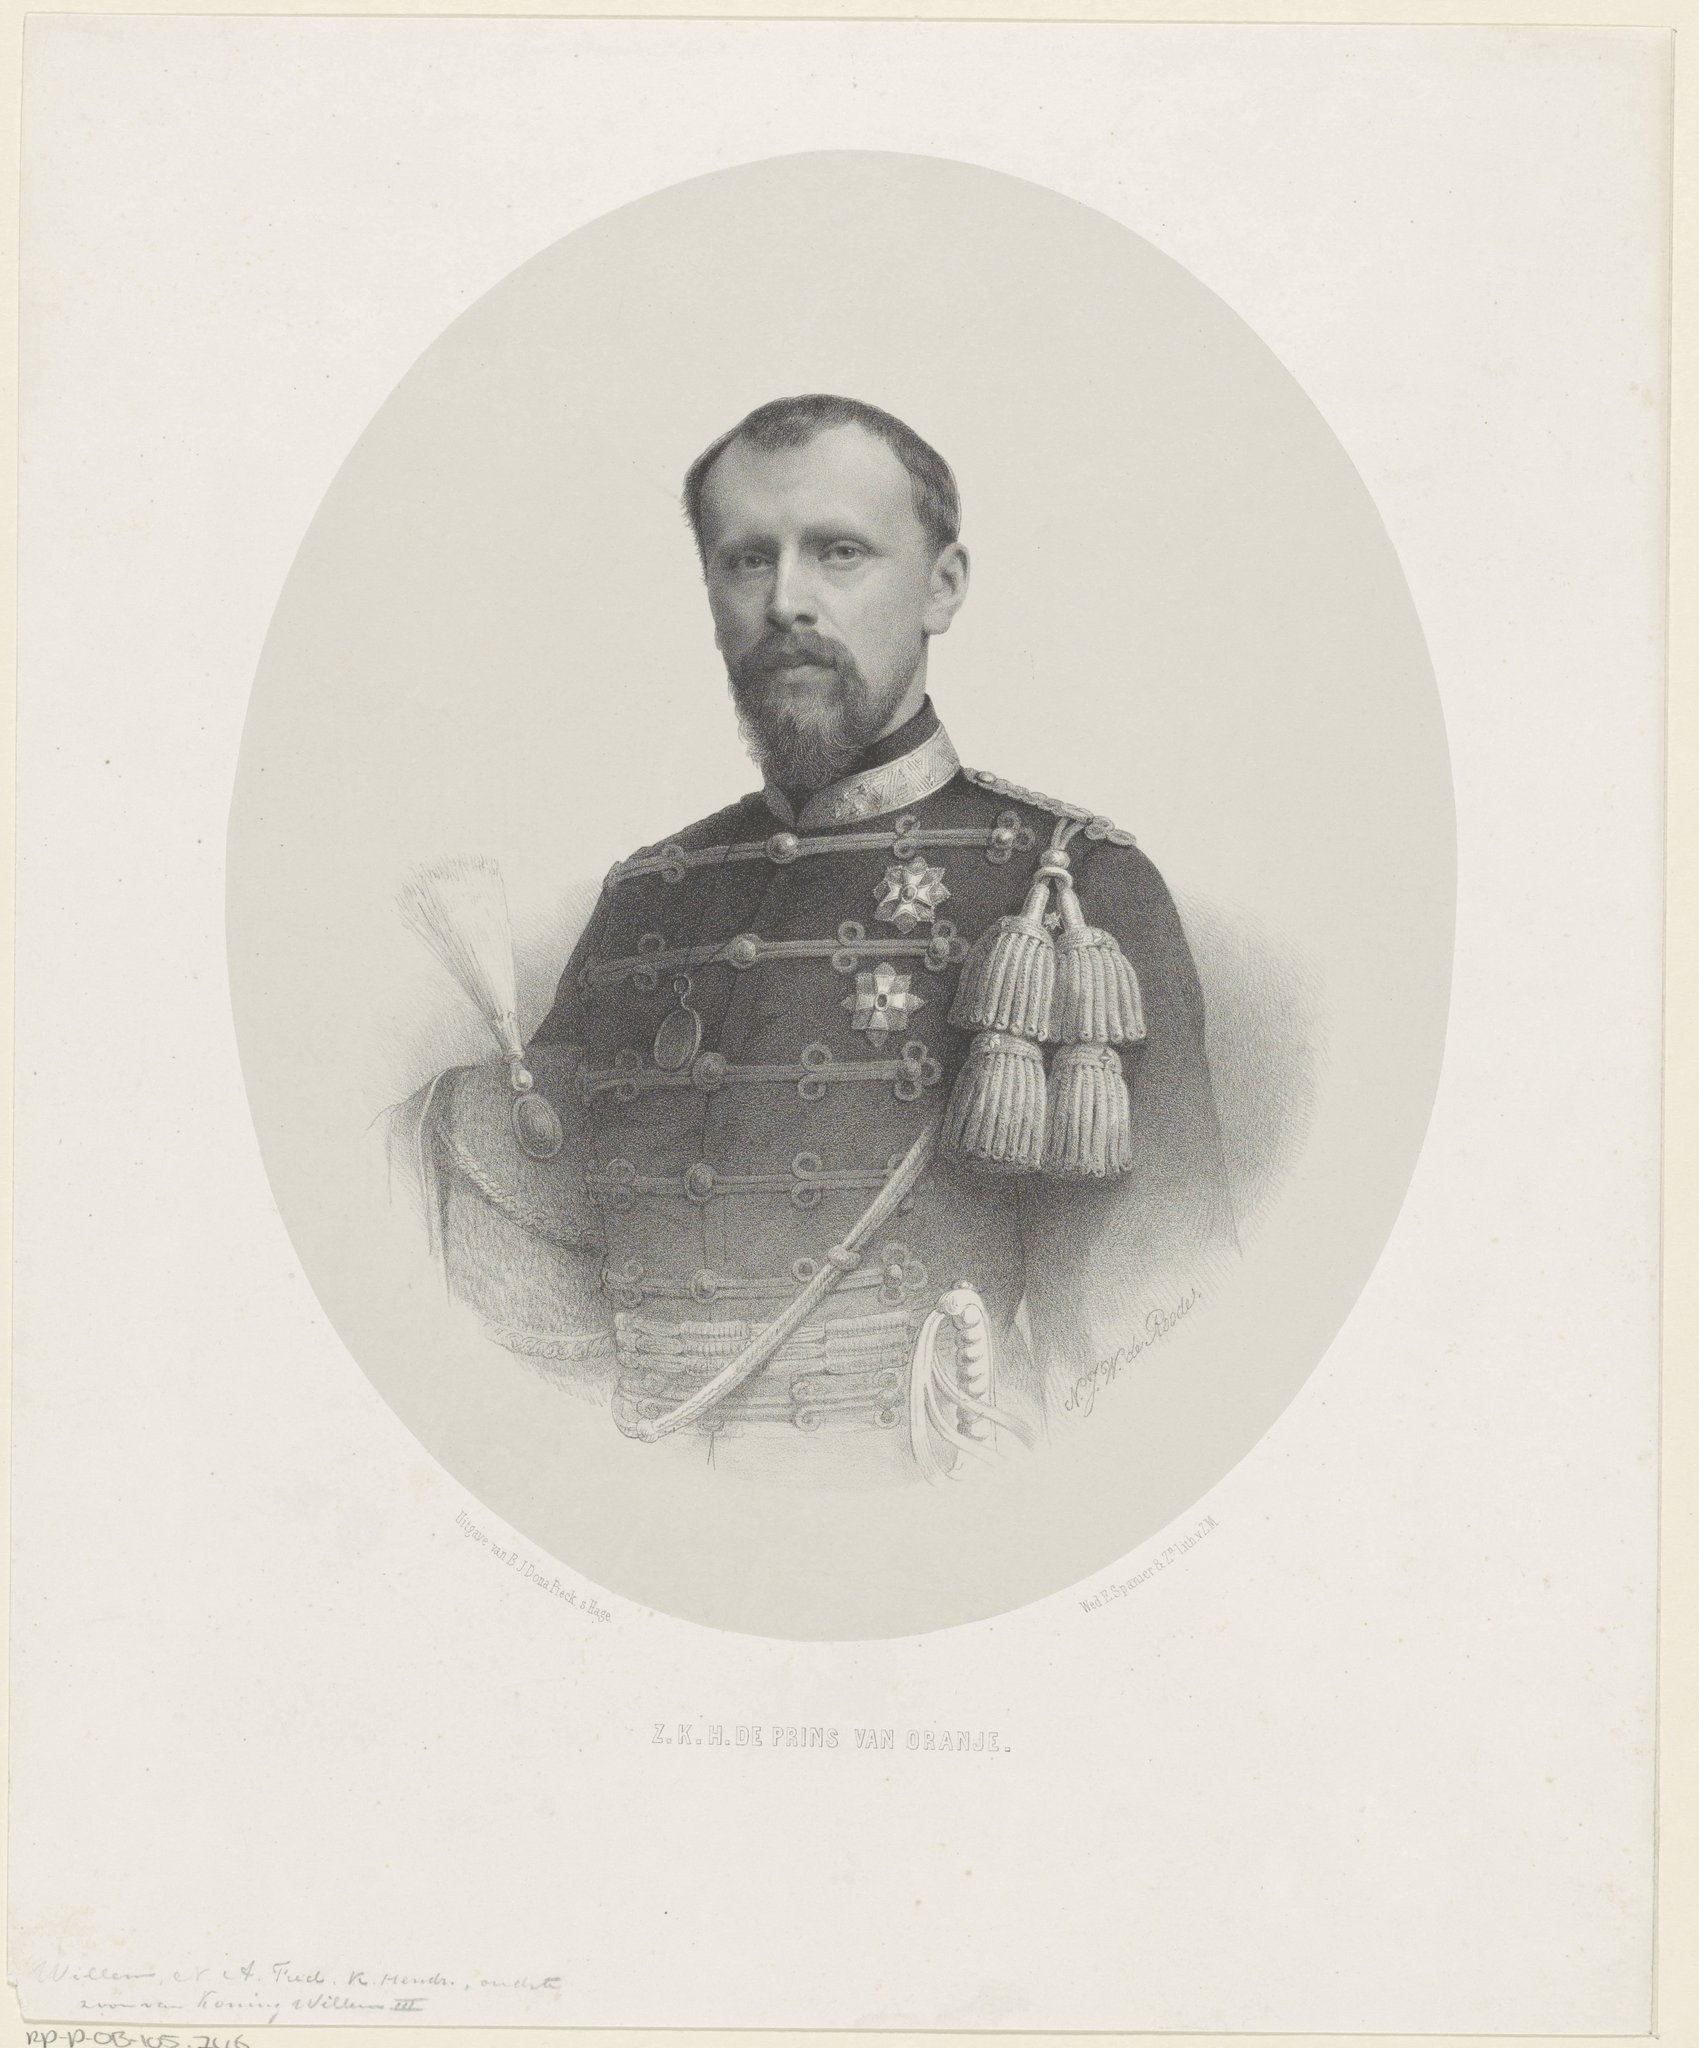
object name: print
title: Portret van Willem, prins der Nederlanden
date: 1865-1884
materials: paper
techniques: lithograph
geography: the hague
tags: the hague, paris, willem (prins der nederlanden)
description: De hier vermelde titel verwijst naar de hoogst verkregen titel van de geportretteerde, niet per se naar de titel die de geportretteerde op deze voorstelling draagt.